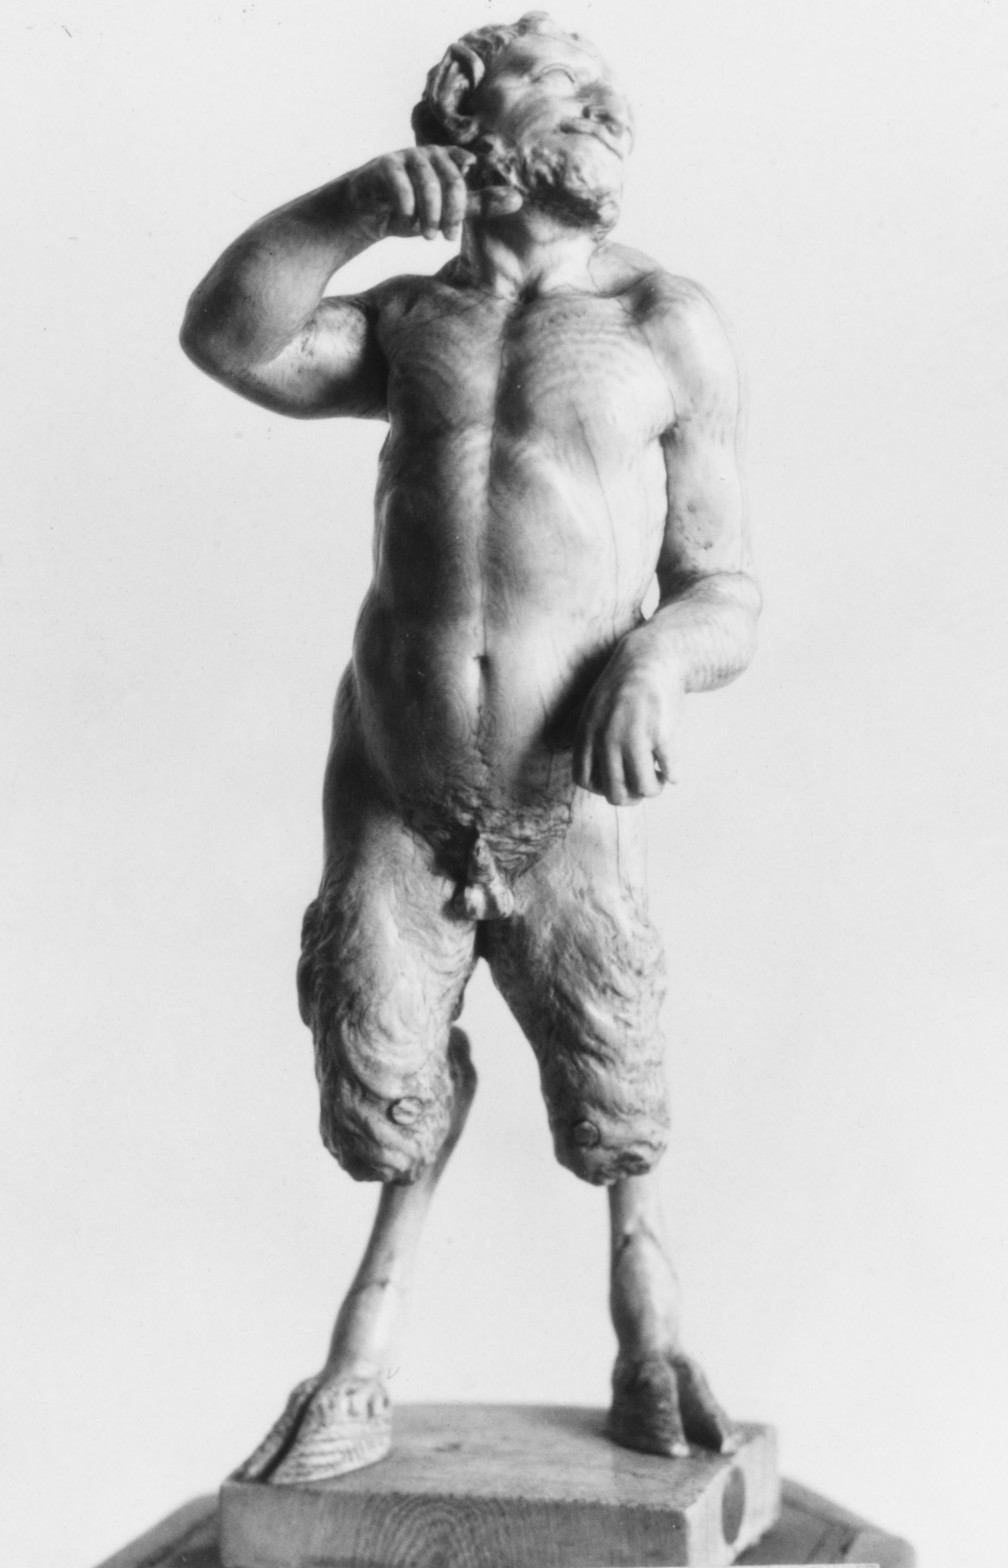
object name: statuette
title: Satyr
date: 1601-1700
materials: ivory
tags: satyrs